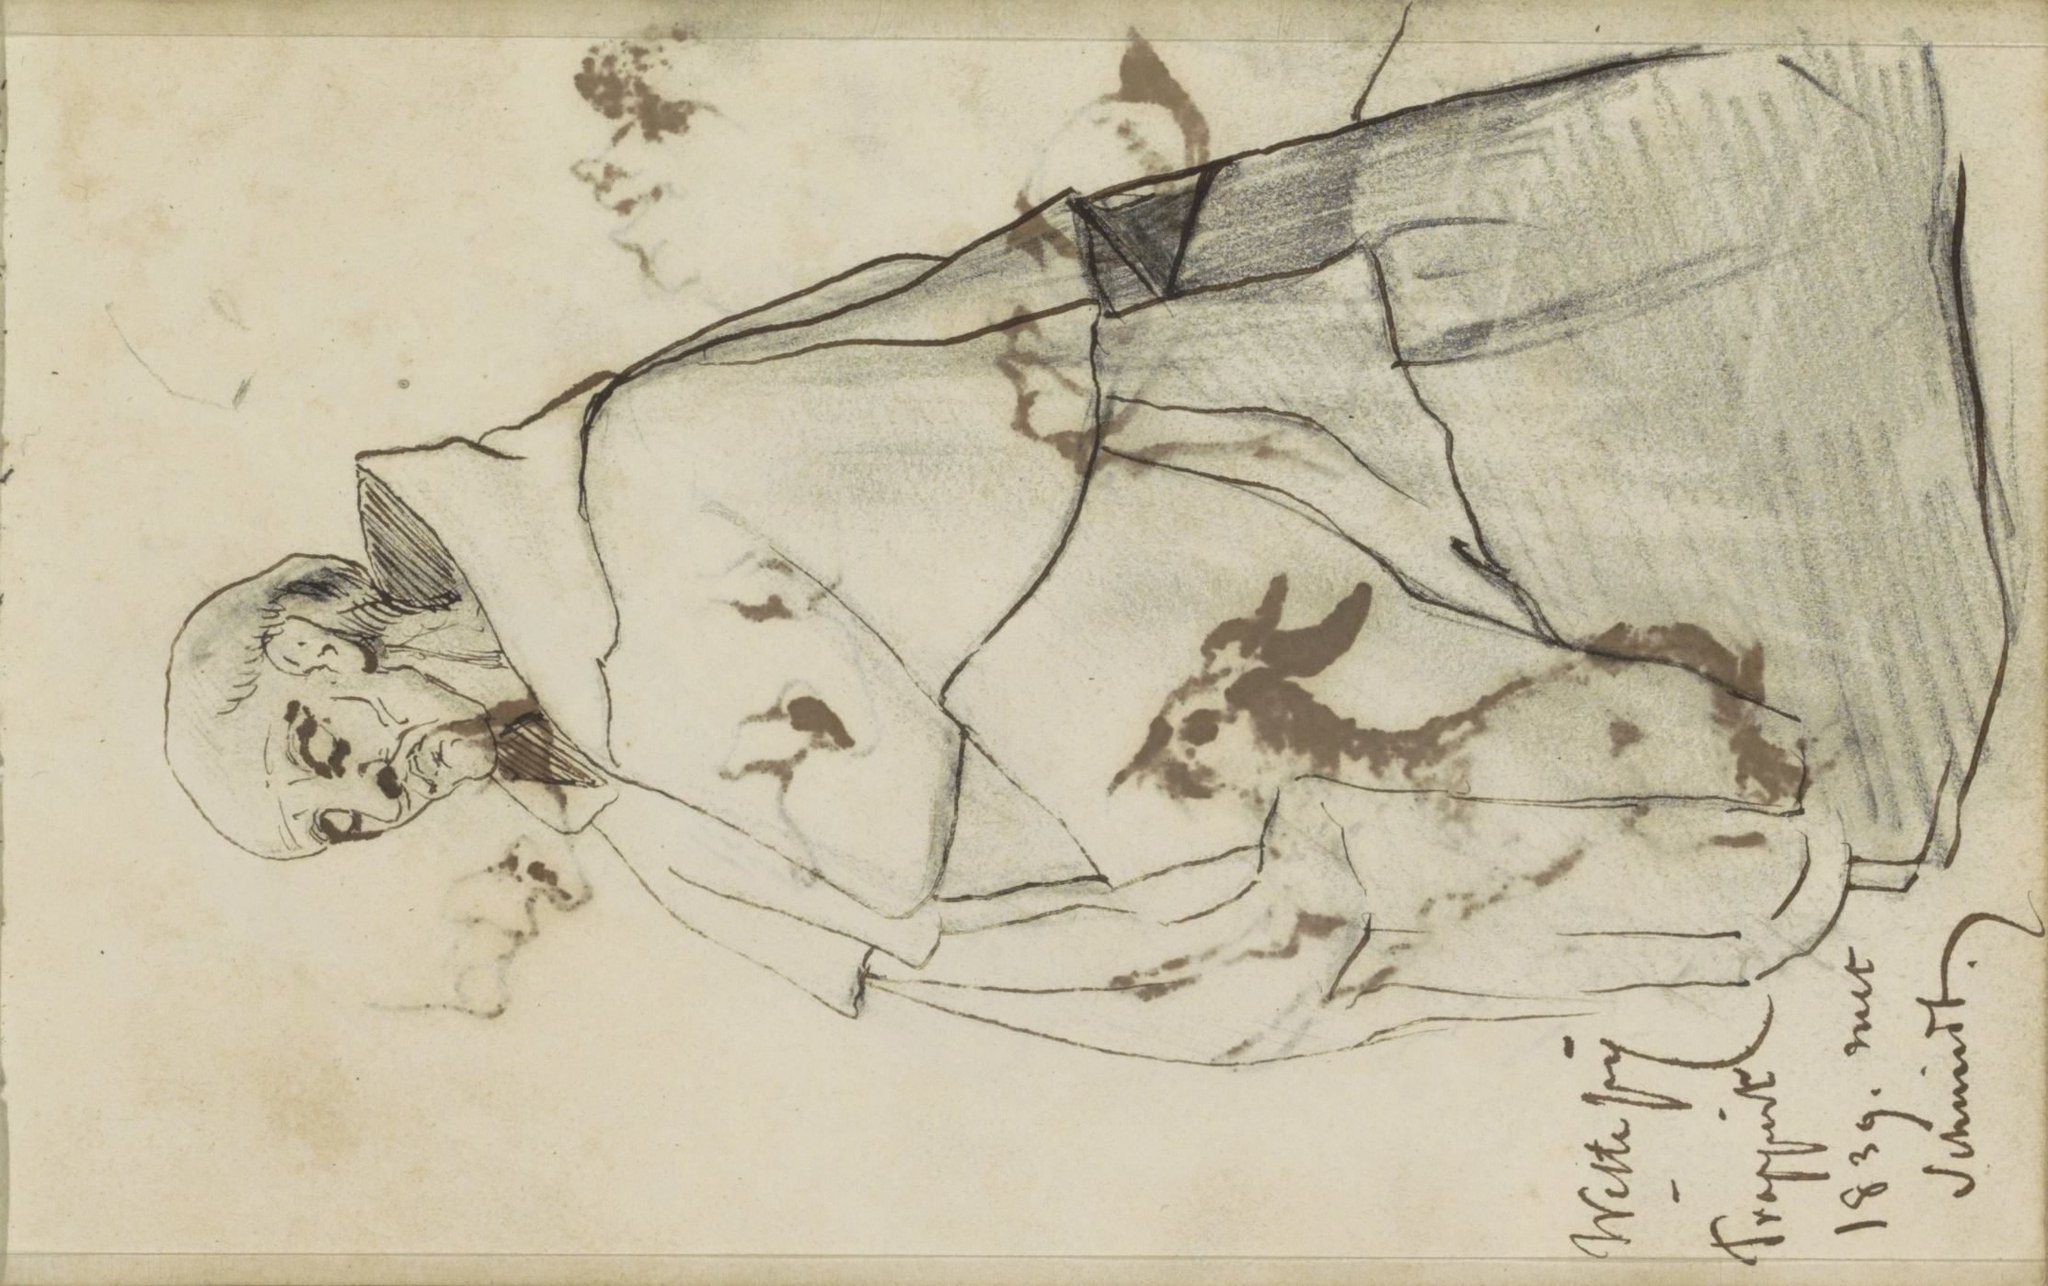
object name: sketchbook leaf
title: Trappist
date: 1839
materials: paper, pencil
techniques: pen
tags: monk(s), friar(s)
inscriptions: date and inscription: ‘witte pij/ Trappist/ 1839. met/ Schmidt.’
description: Blad 12 recto uit een schetsboek met 37 bladen.